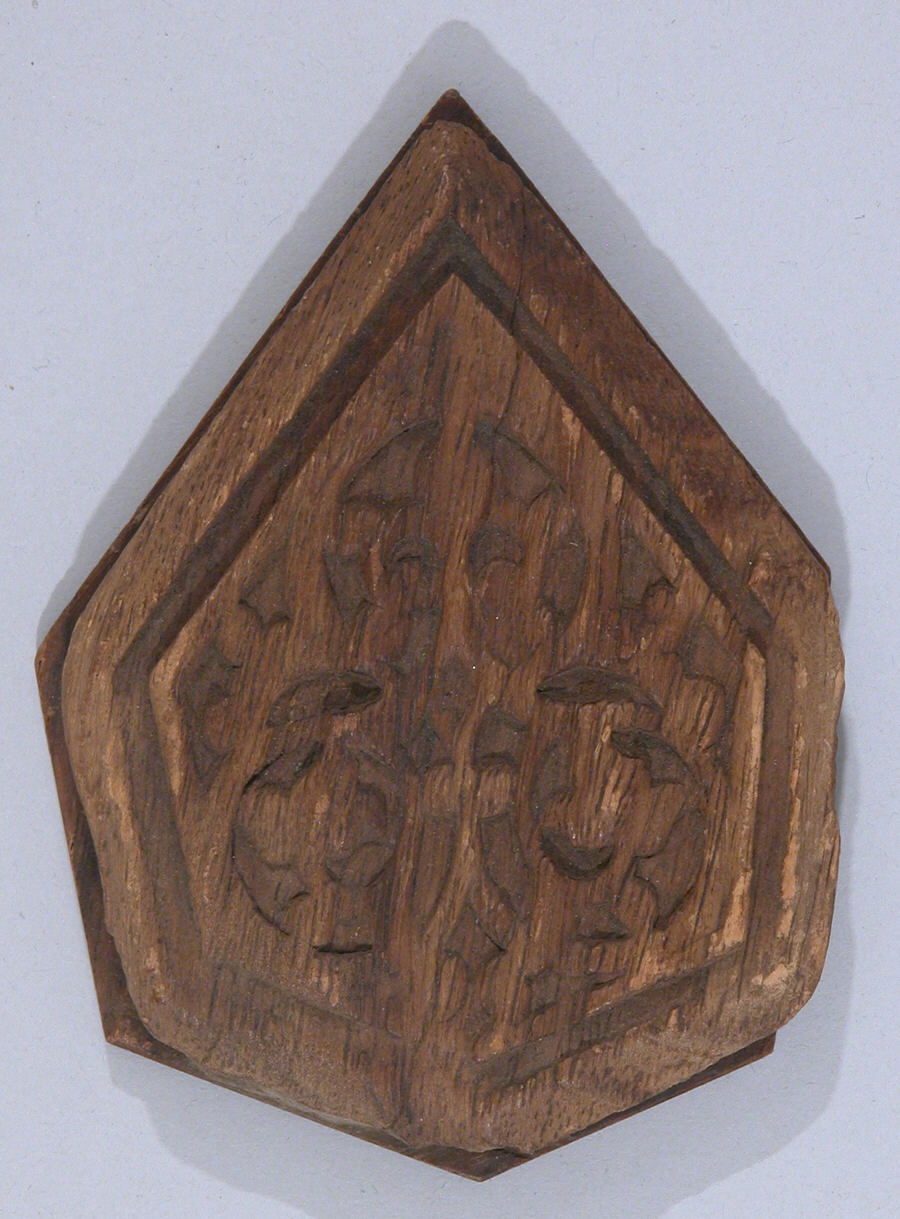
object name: panel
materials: wood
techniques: carving, inlay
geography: egypt